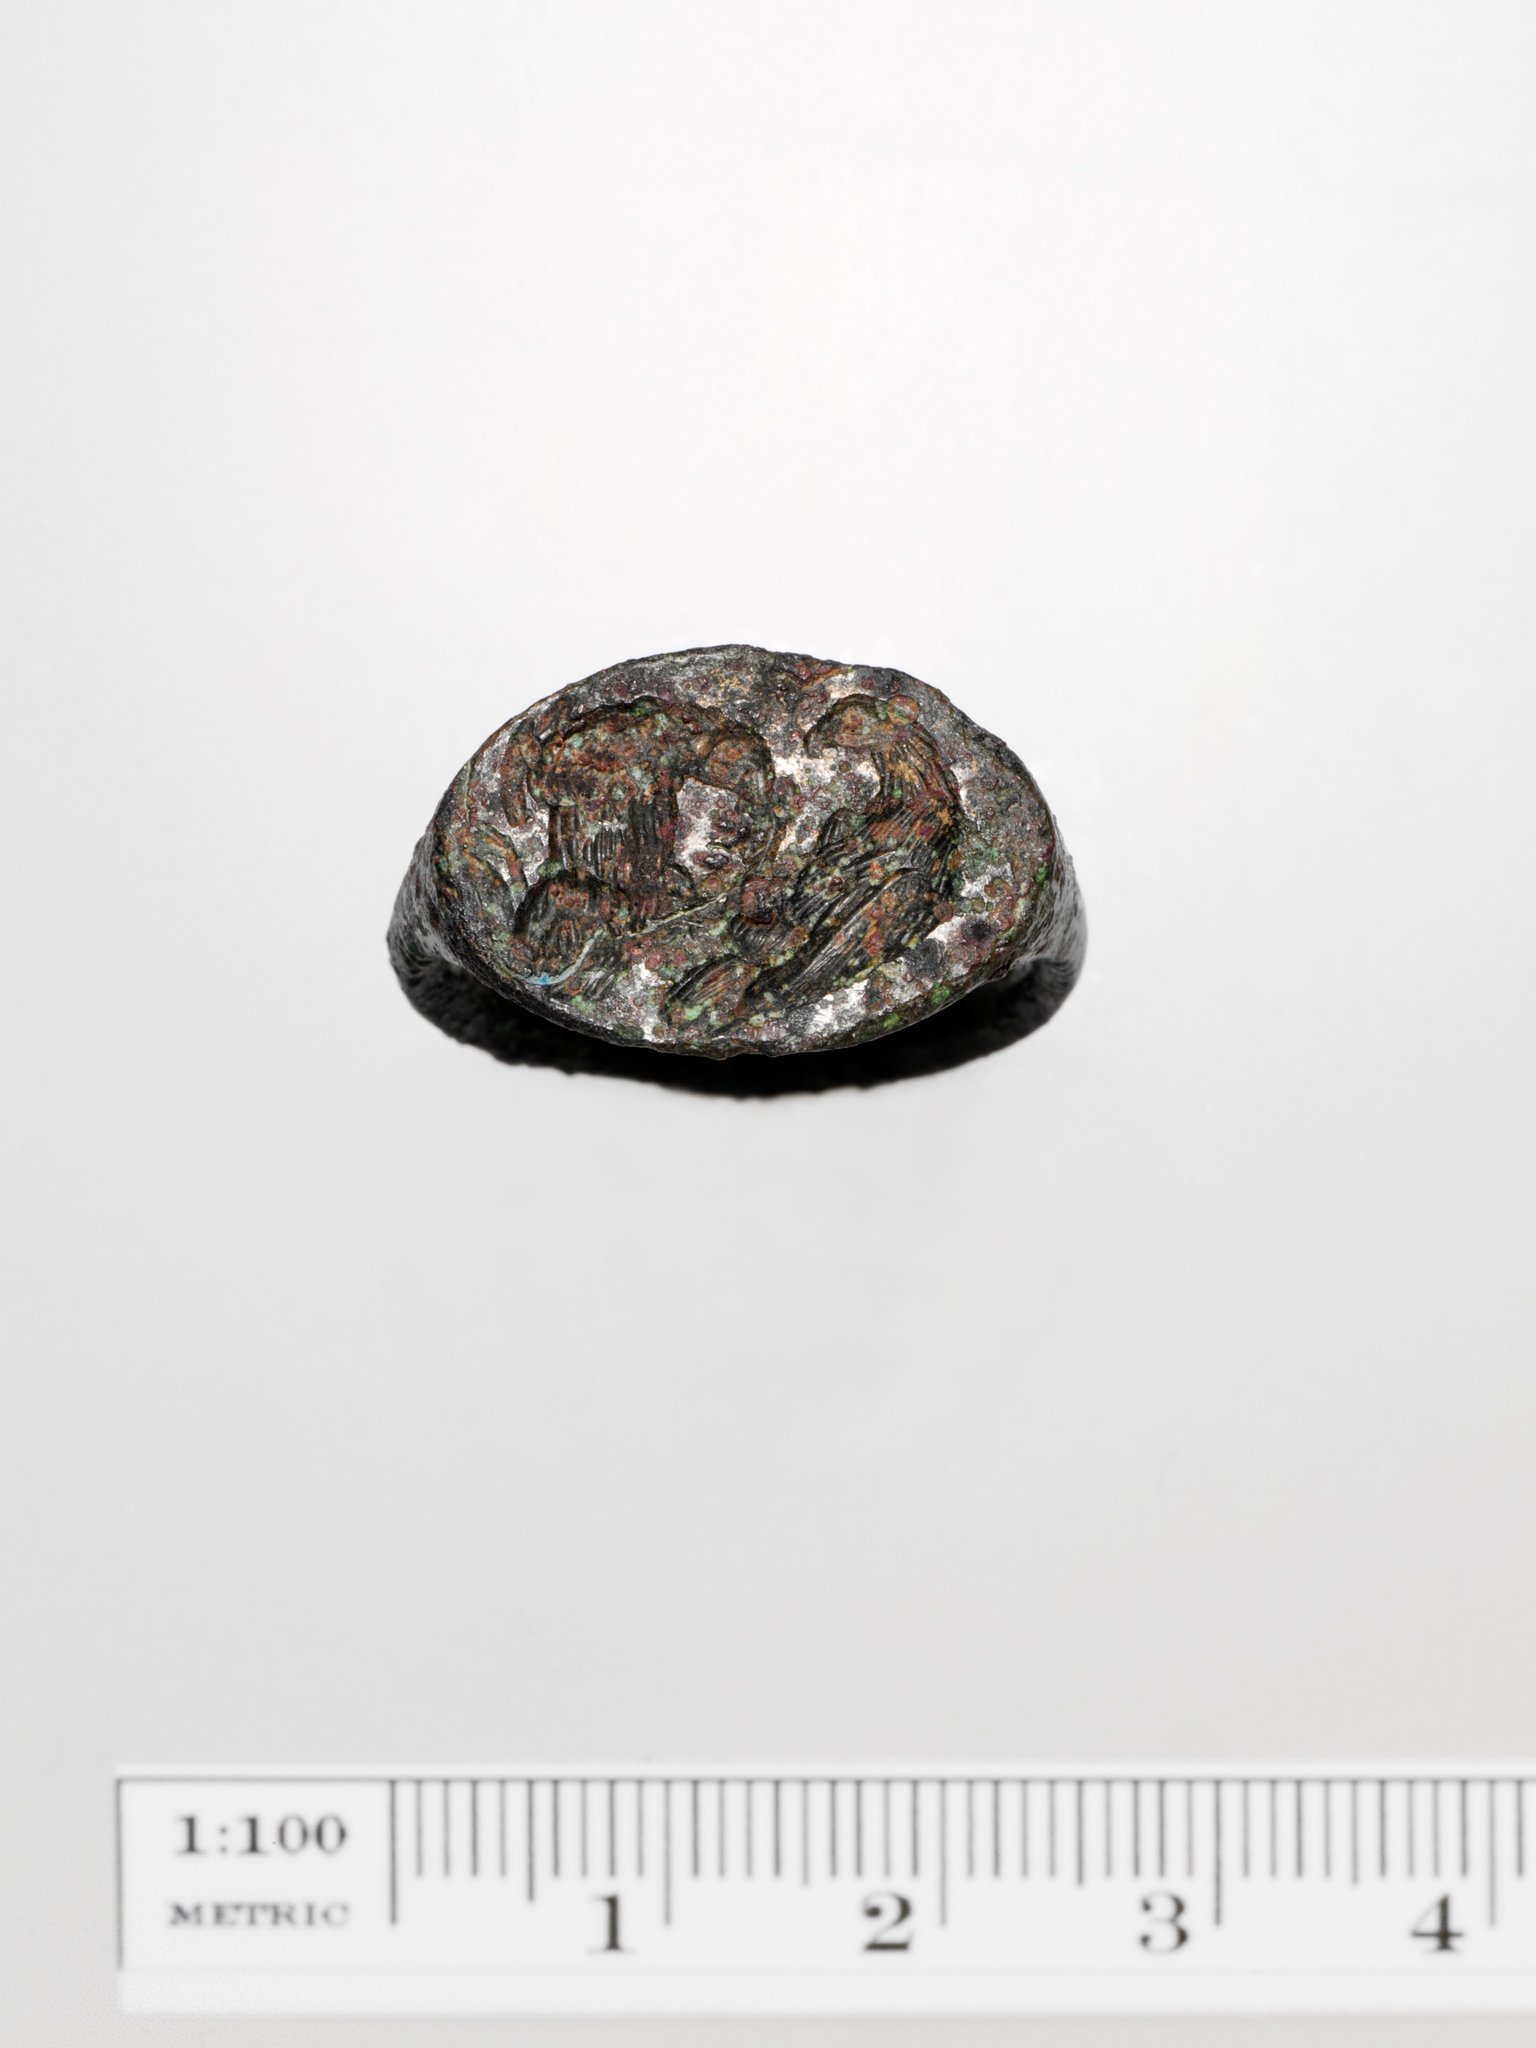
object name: ring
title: Bronze ring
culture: greek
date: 500-301 BCE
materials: bronze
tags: eagles,rams